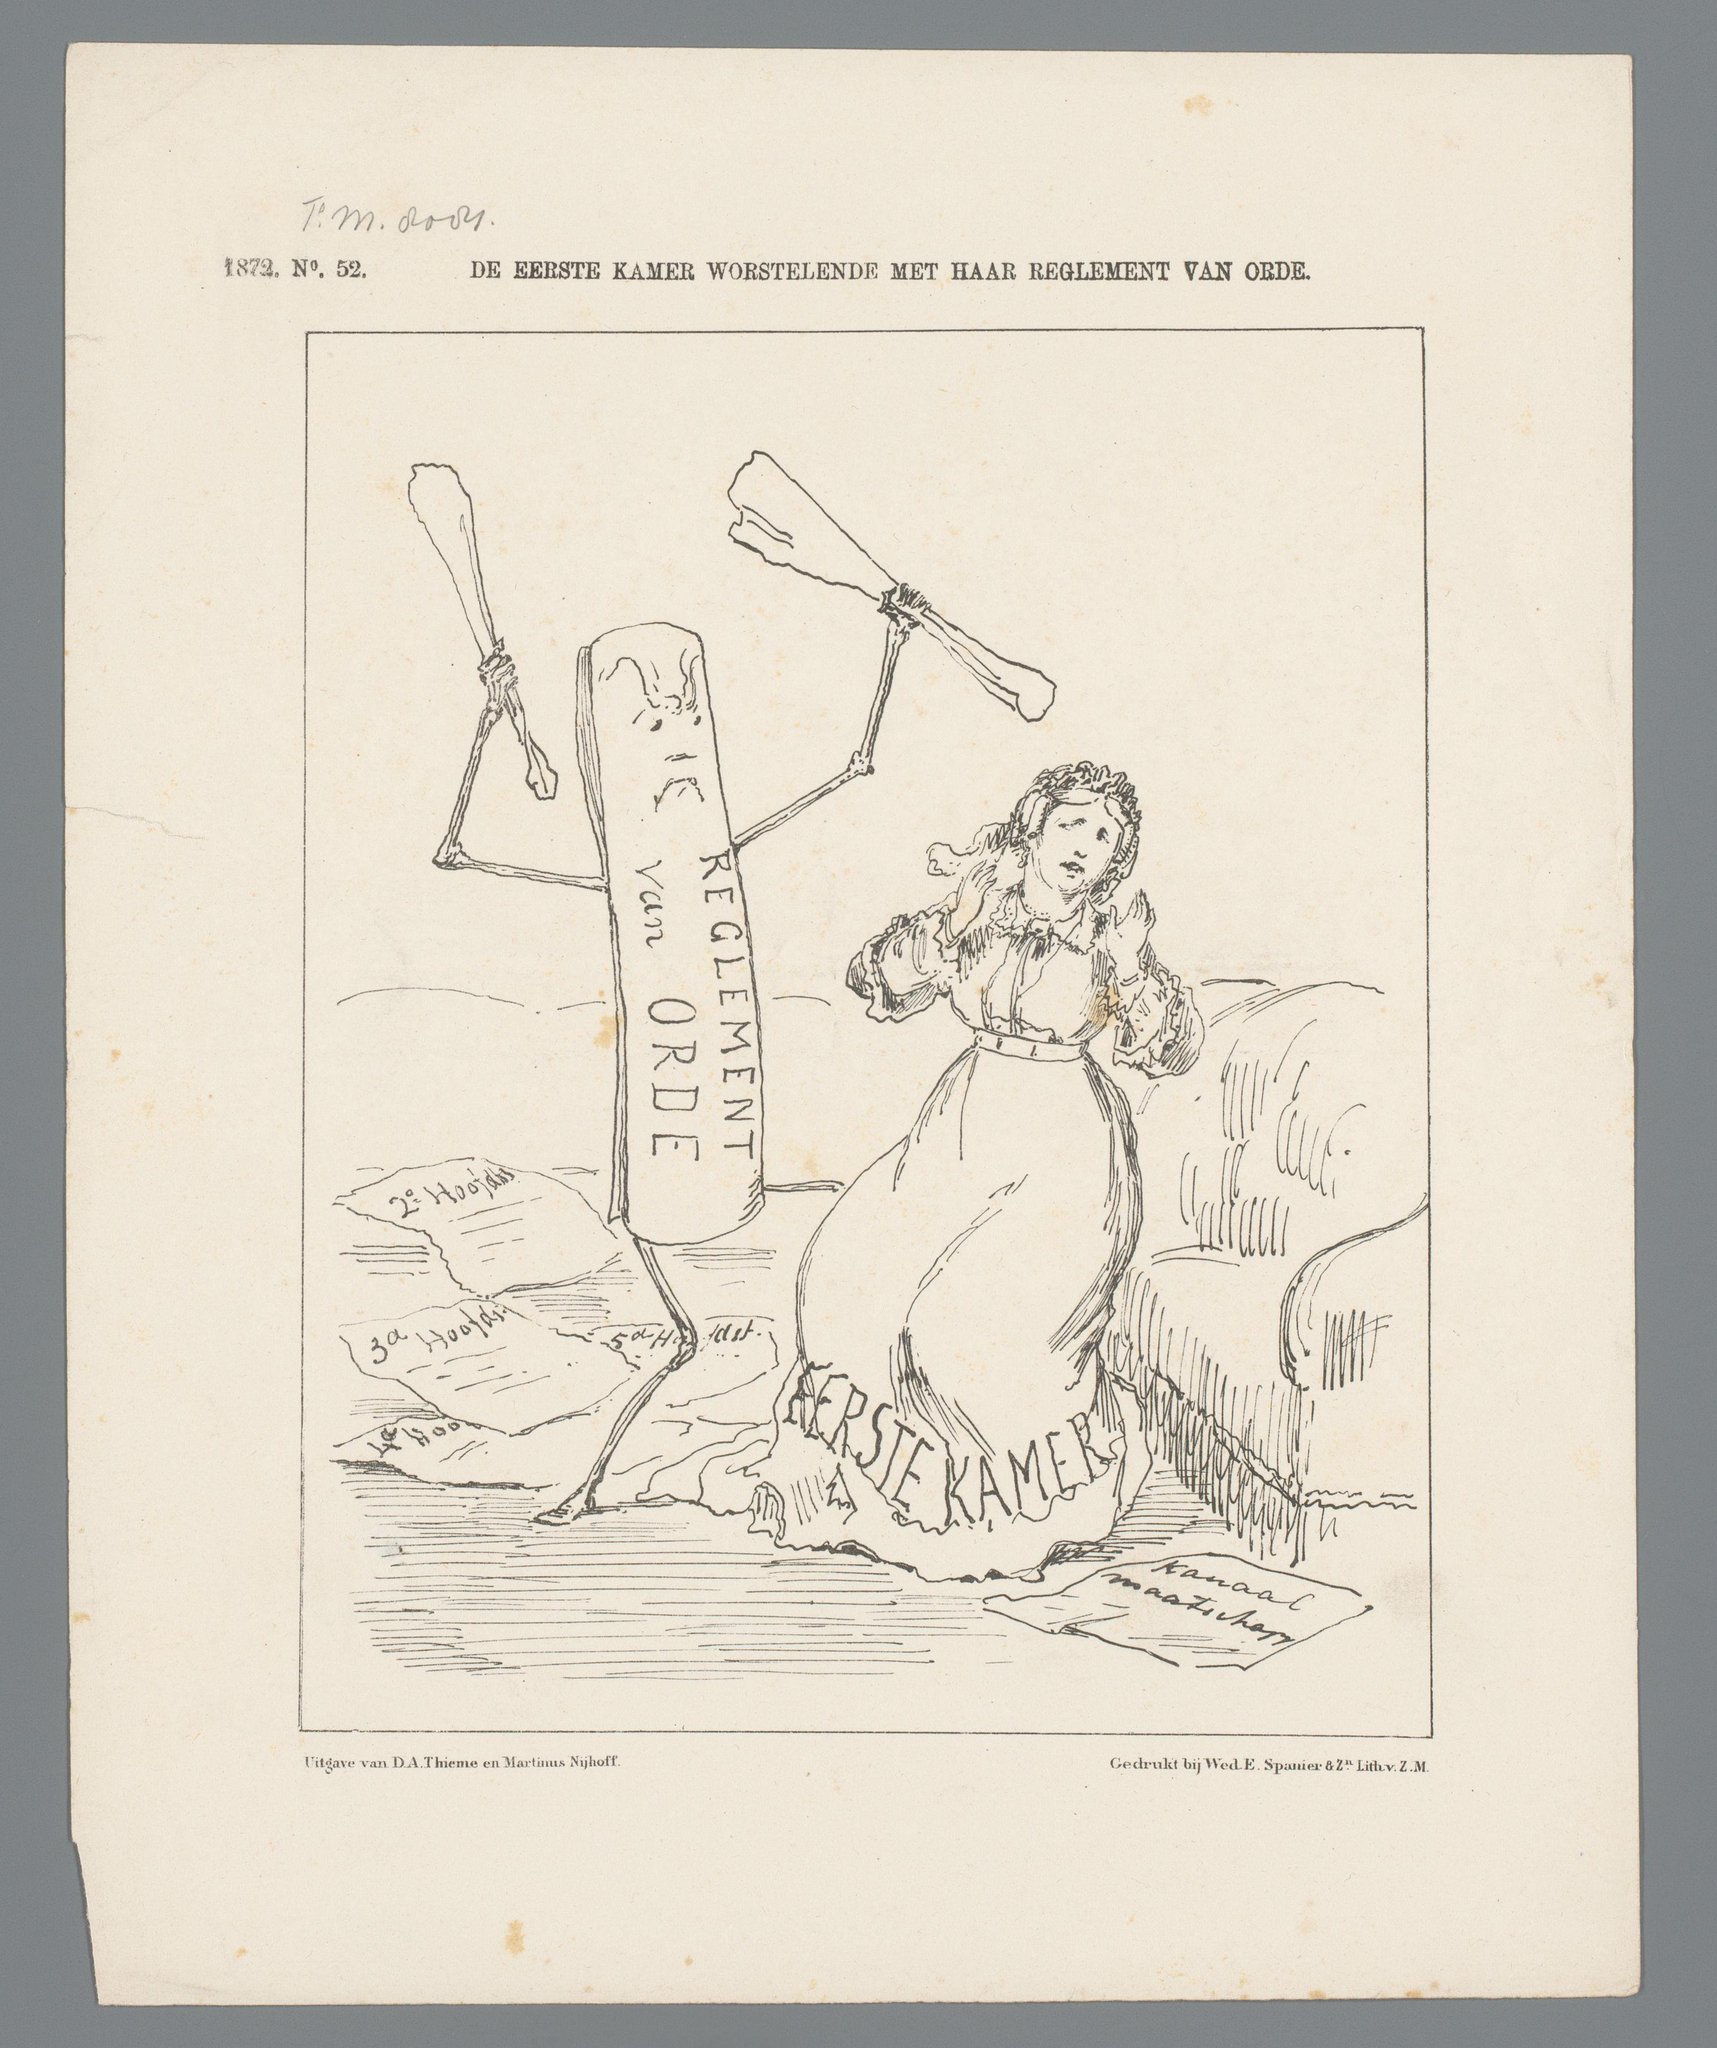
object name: cartoon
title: De Eerste Kamer worstelende met haar reglement van orde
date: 1872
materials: paper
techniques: lithograph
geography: arnhem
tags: upper house, senate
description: Spotprent over het reglement van orde in de Eerste Kamer. Plaat verschenen bij het weekblad De Nederlandsche Spectator, nr. 52, 1872.